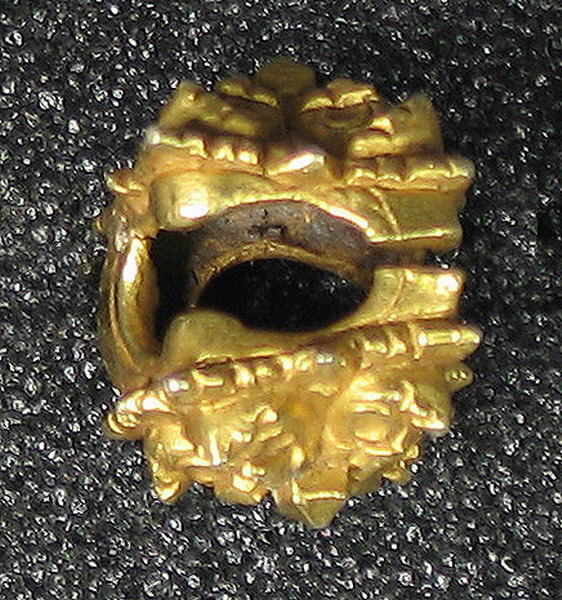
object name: earring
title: Earrings with Foliate Decoration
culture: indonesian, central java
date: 701-1200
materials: gold